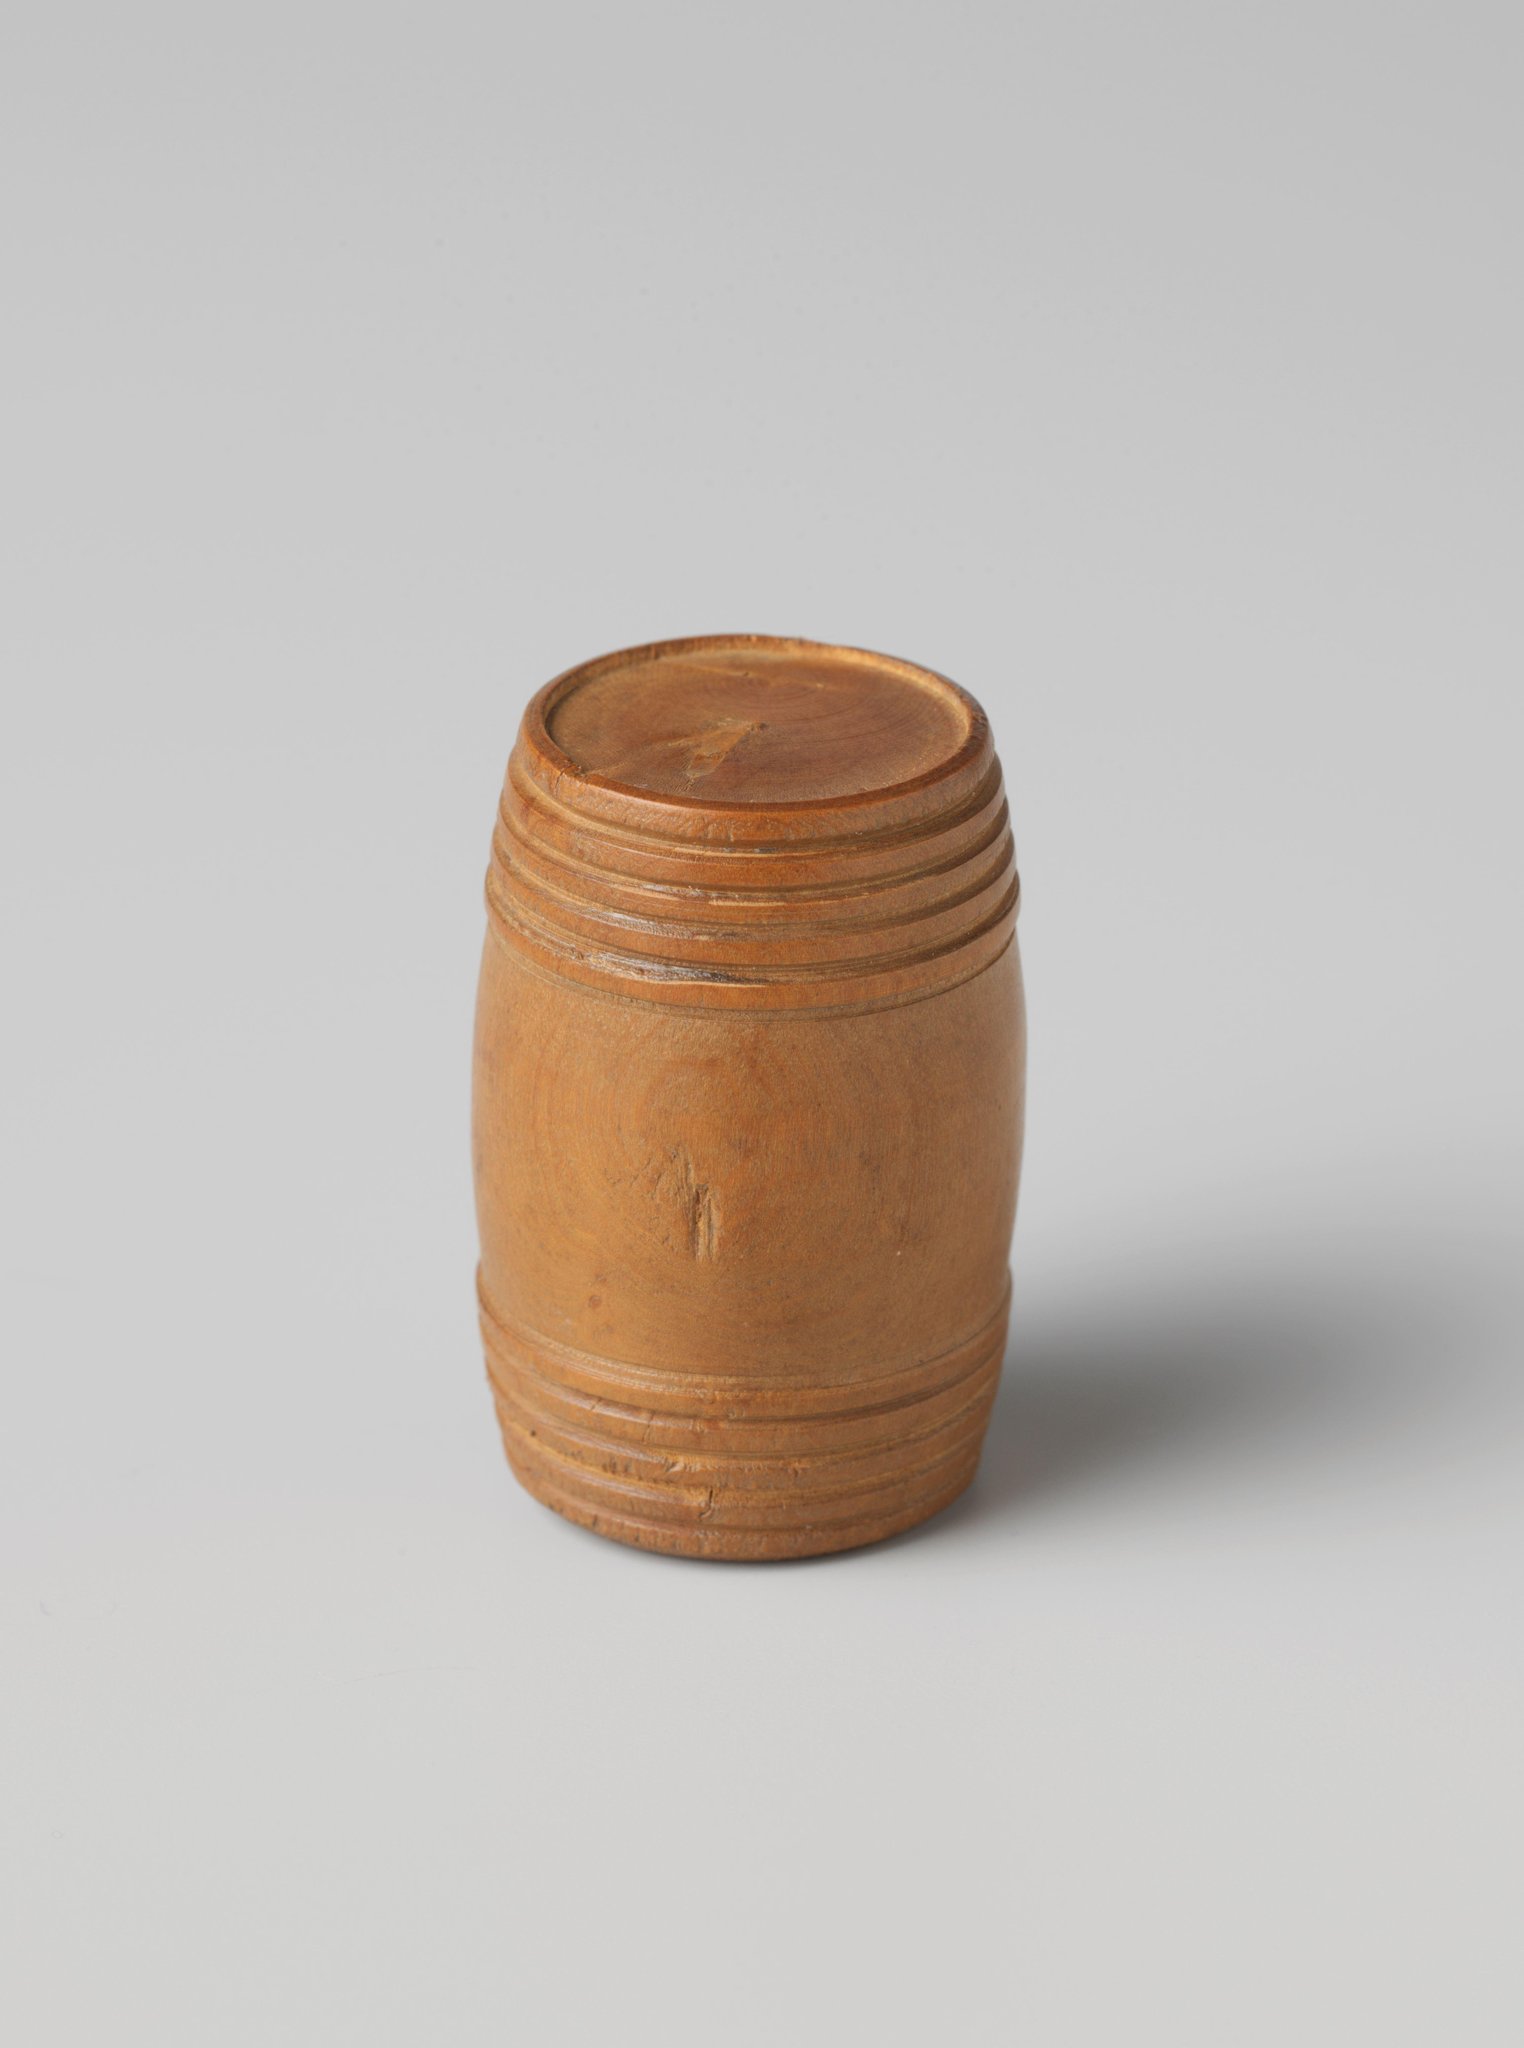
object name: miniature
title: Vat van gedraaid, massief hout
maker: Anonymous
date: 1700-1799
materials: wood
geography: amsterdam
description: Een vat gedraaid van massief esdoornhout.